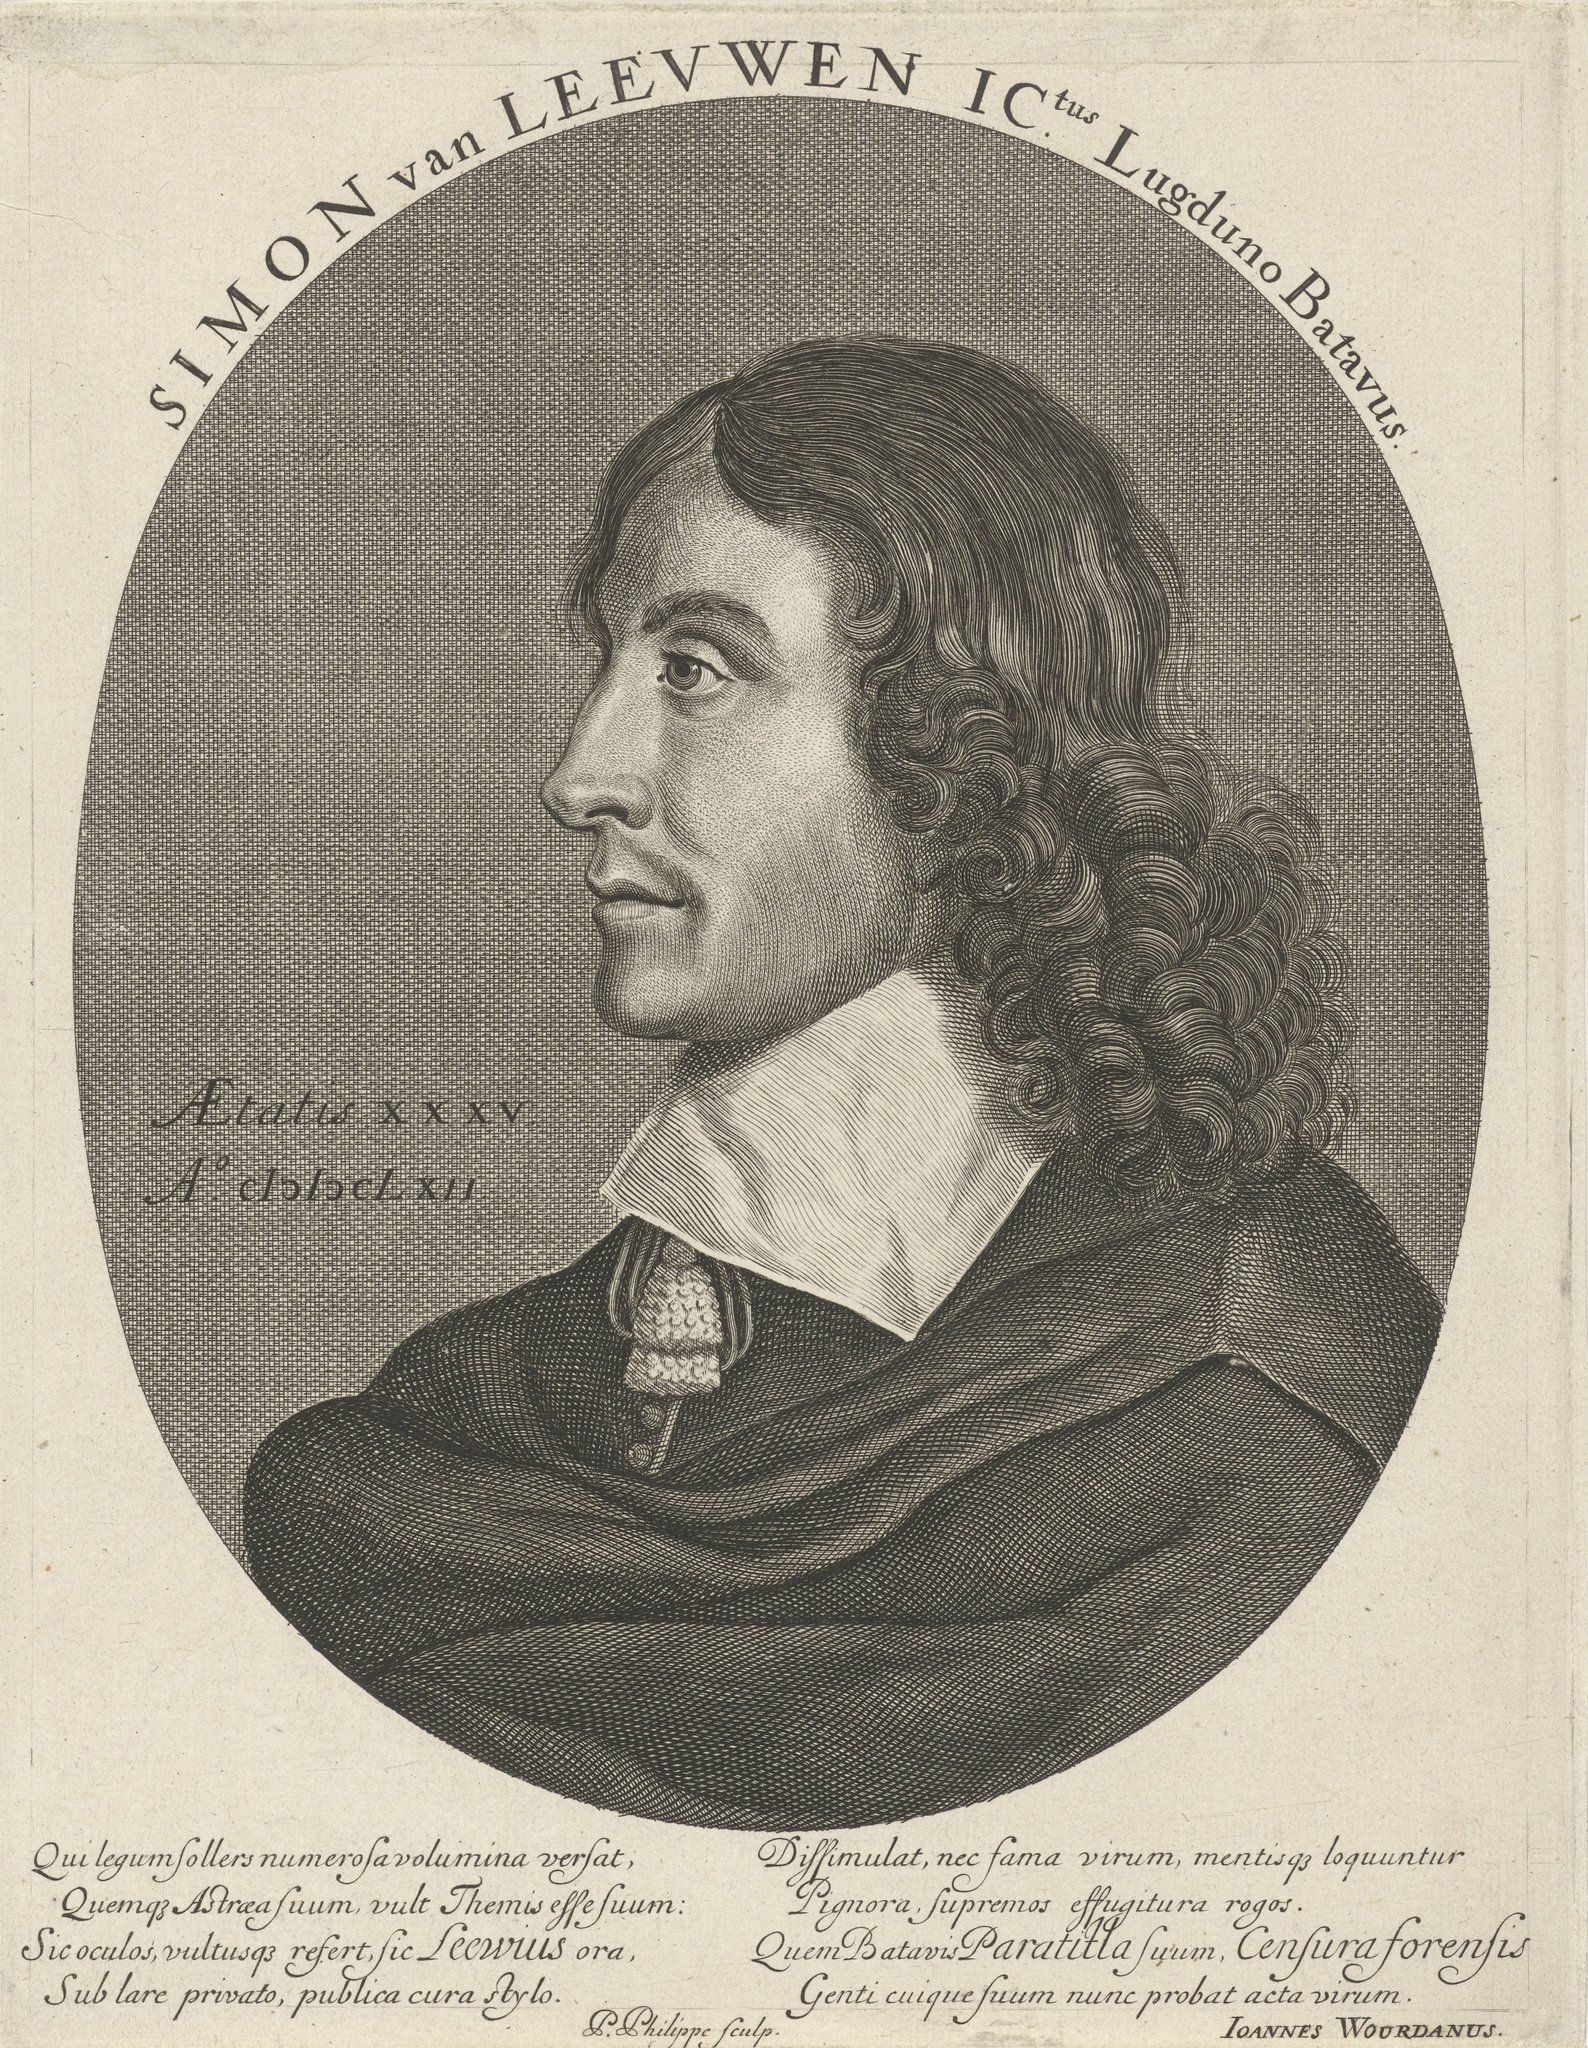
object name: print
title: Portret van Simon van Leeuwen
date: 1662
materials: paper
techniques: engraving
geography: the hague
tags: leiden, the hague, simon van leeuwen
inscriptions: collector's mark: Lugt 2228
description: Portret van de rechtsgeleerde Simon van Leeuwen, op 35-jarige leeftijd. Hij was advocaat in Den Haag en later in Leiden.